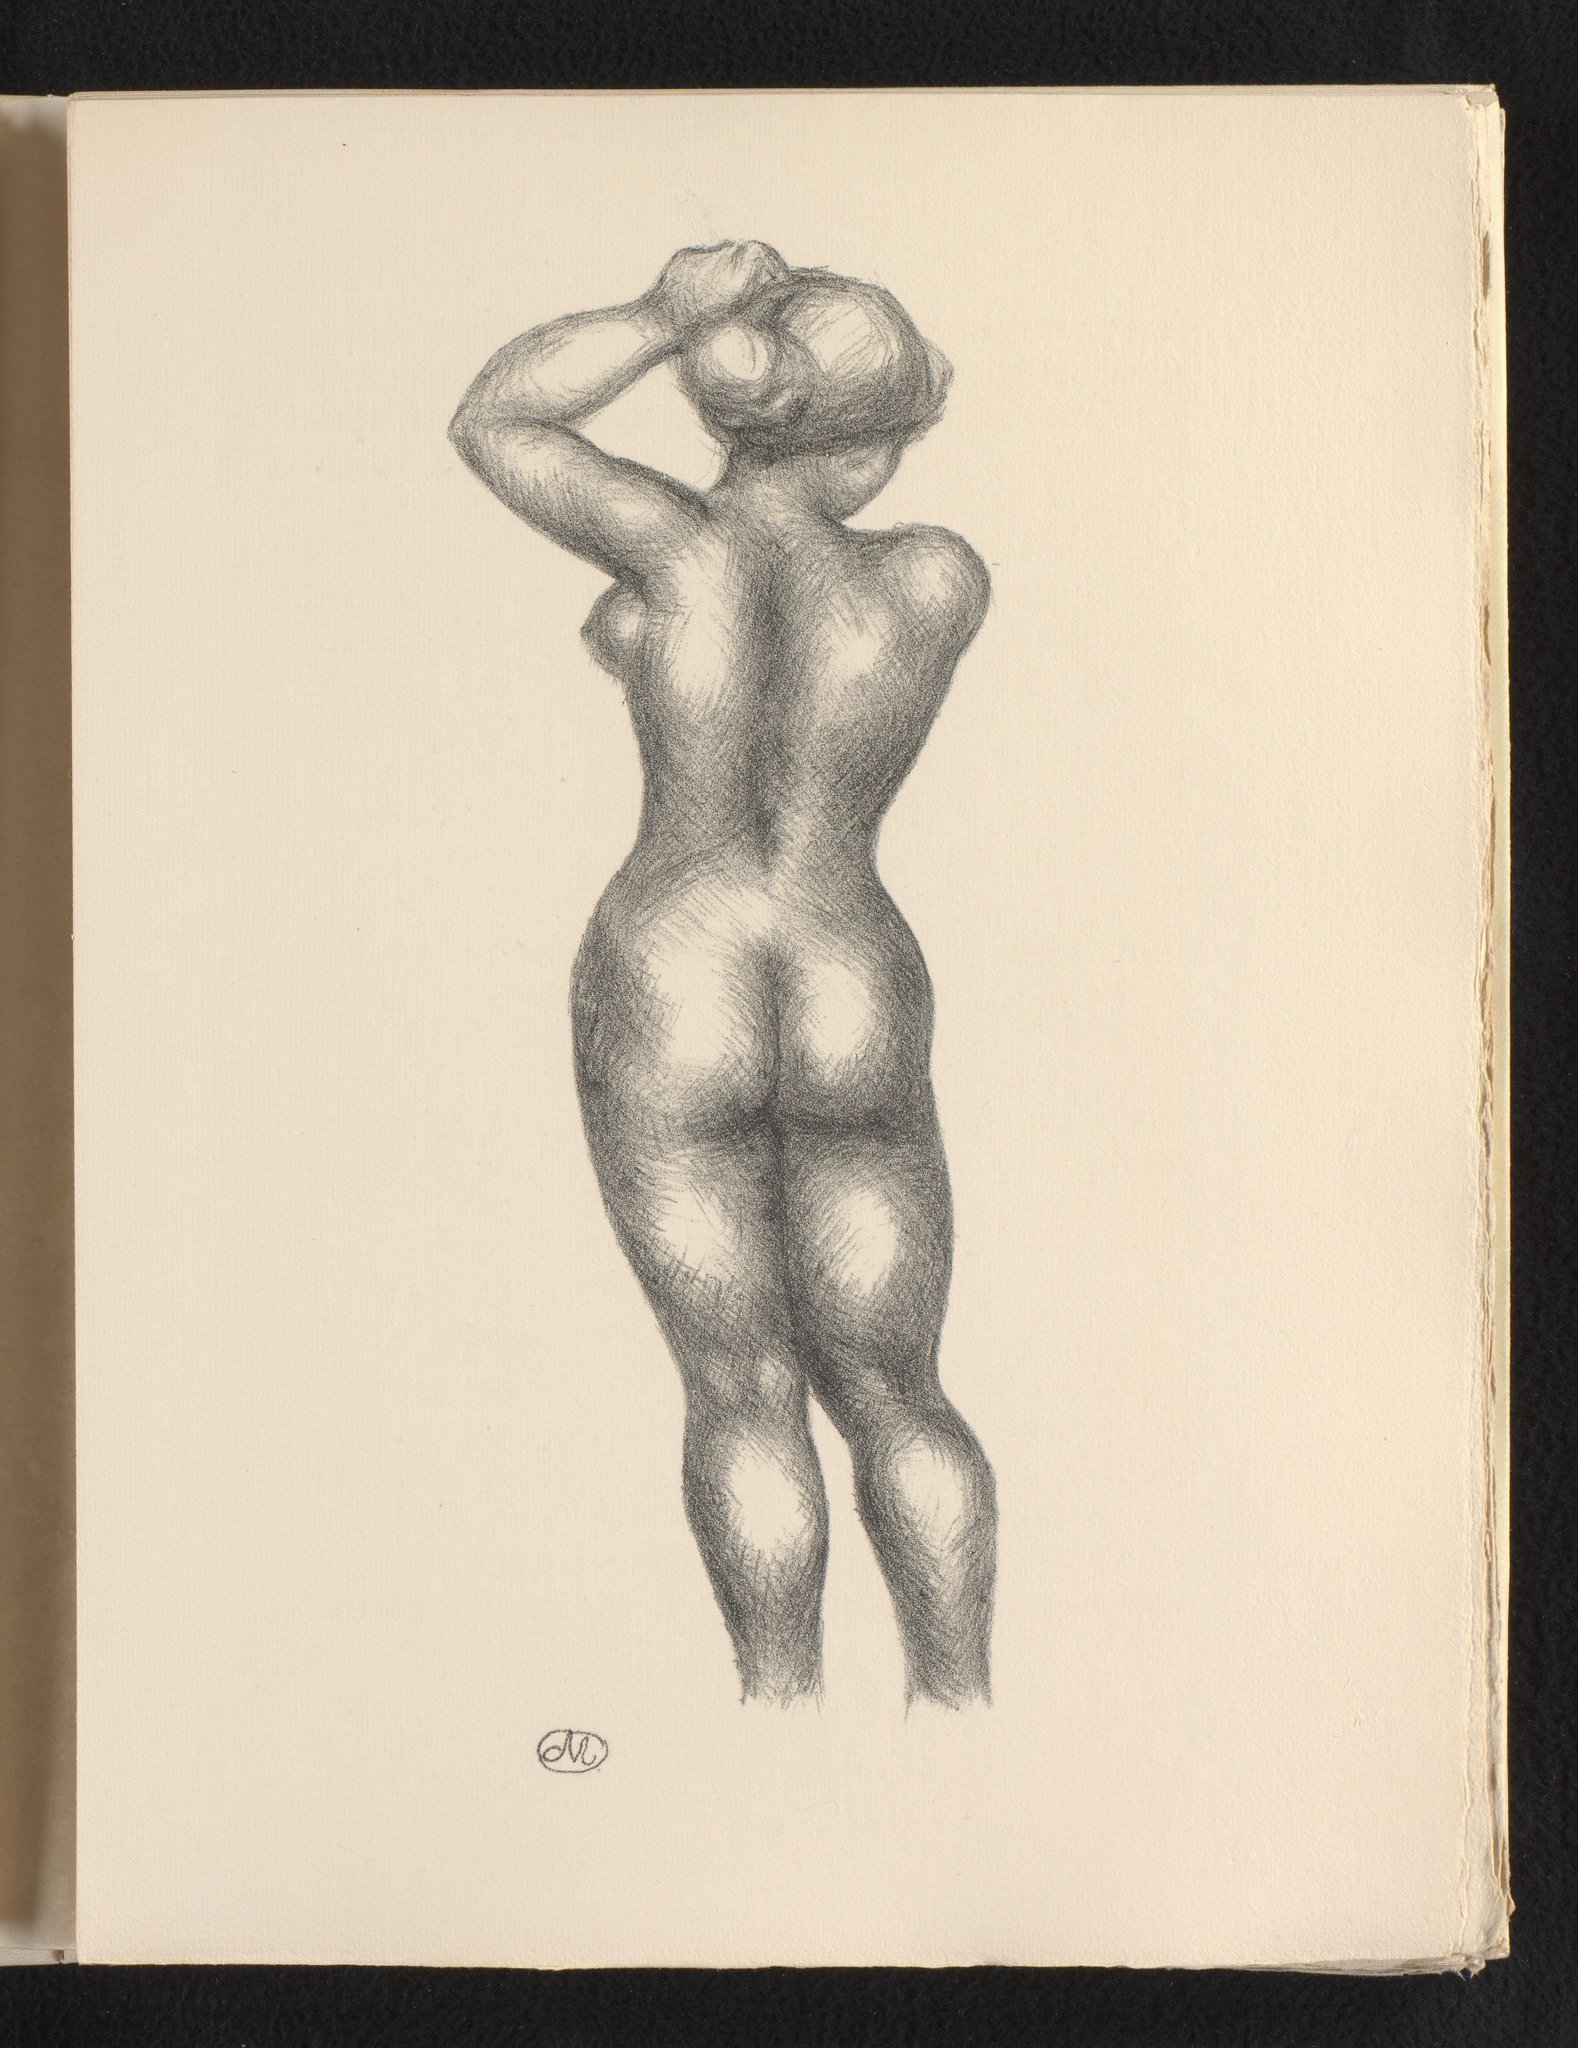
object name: print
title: Staande naakte vrouw, op de rug gezien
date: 1948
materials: paper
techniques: letterpress printing, lithograph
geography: paris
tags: woman (showing herself) undressed, quasi-nude, standing figure - aa - female human figure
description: Prent uit: Lucianus van Samosata. Dialogues des Courtisanes. [Vertaald uit het Grieks door] Charles Astruc. Parijs: s.n., 1948, p. 71.